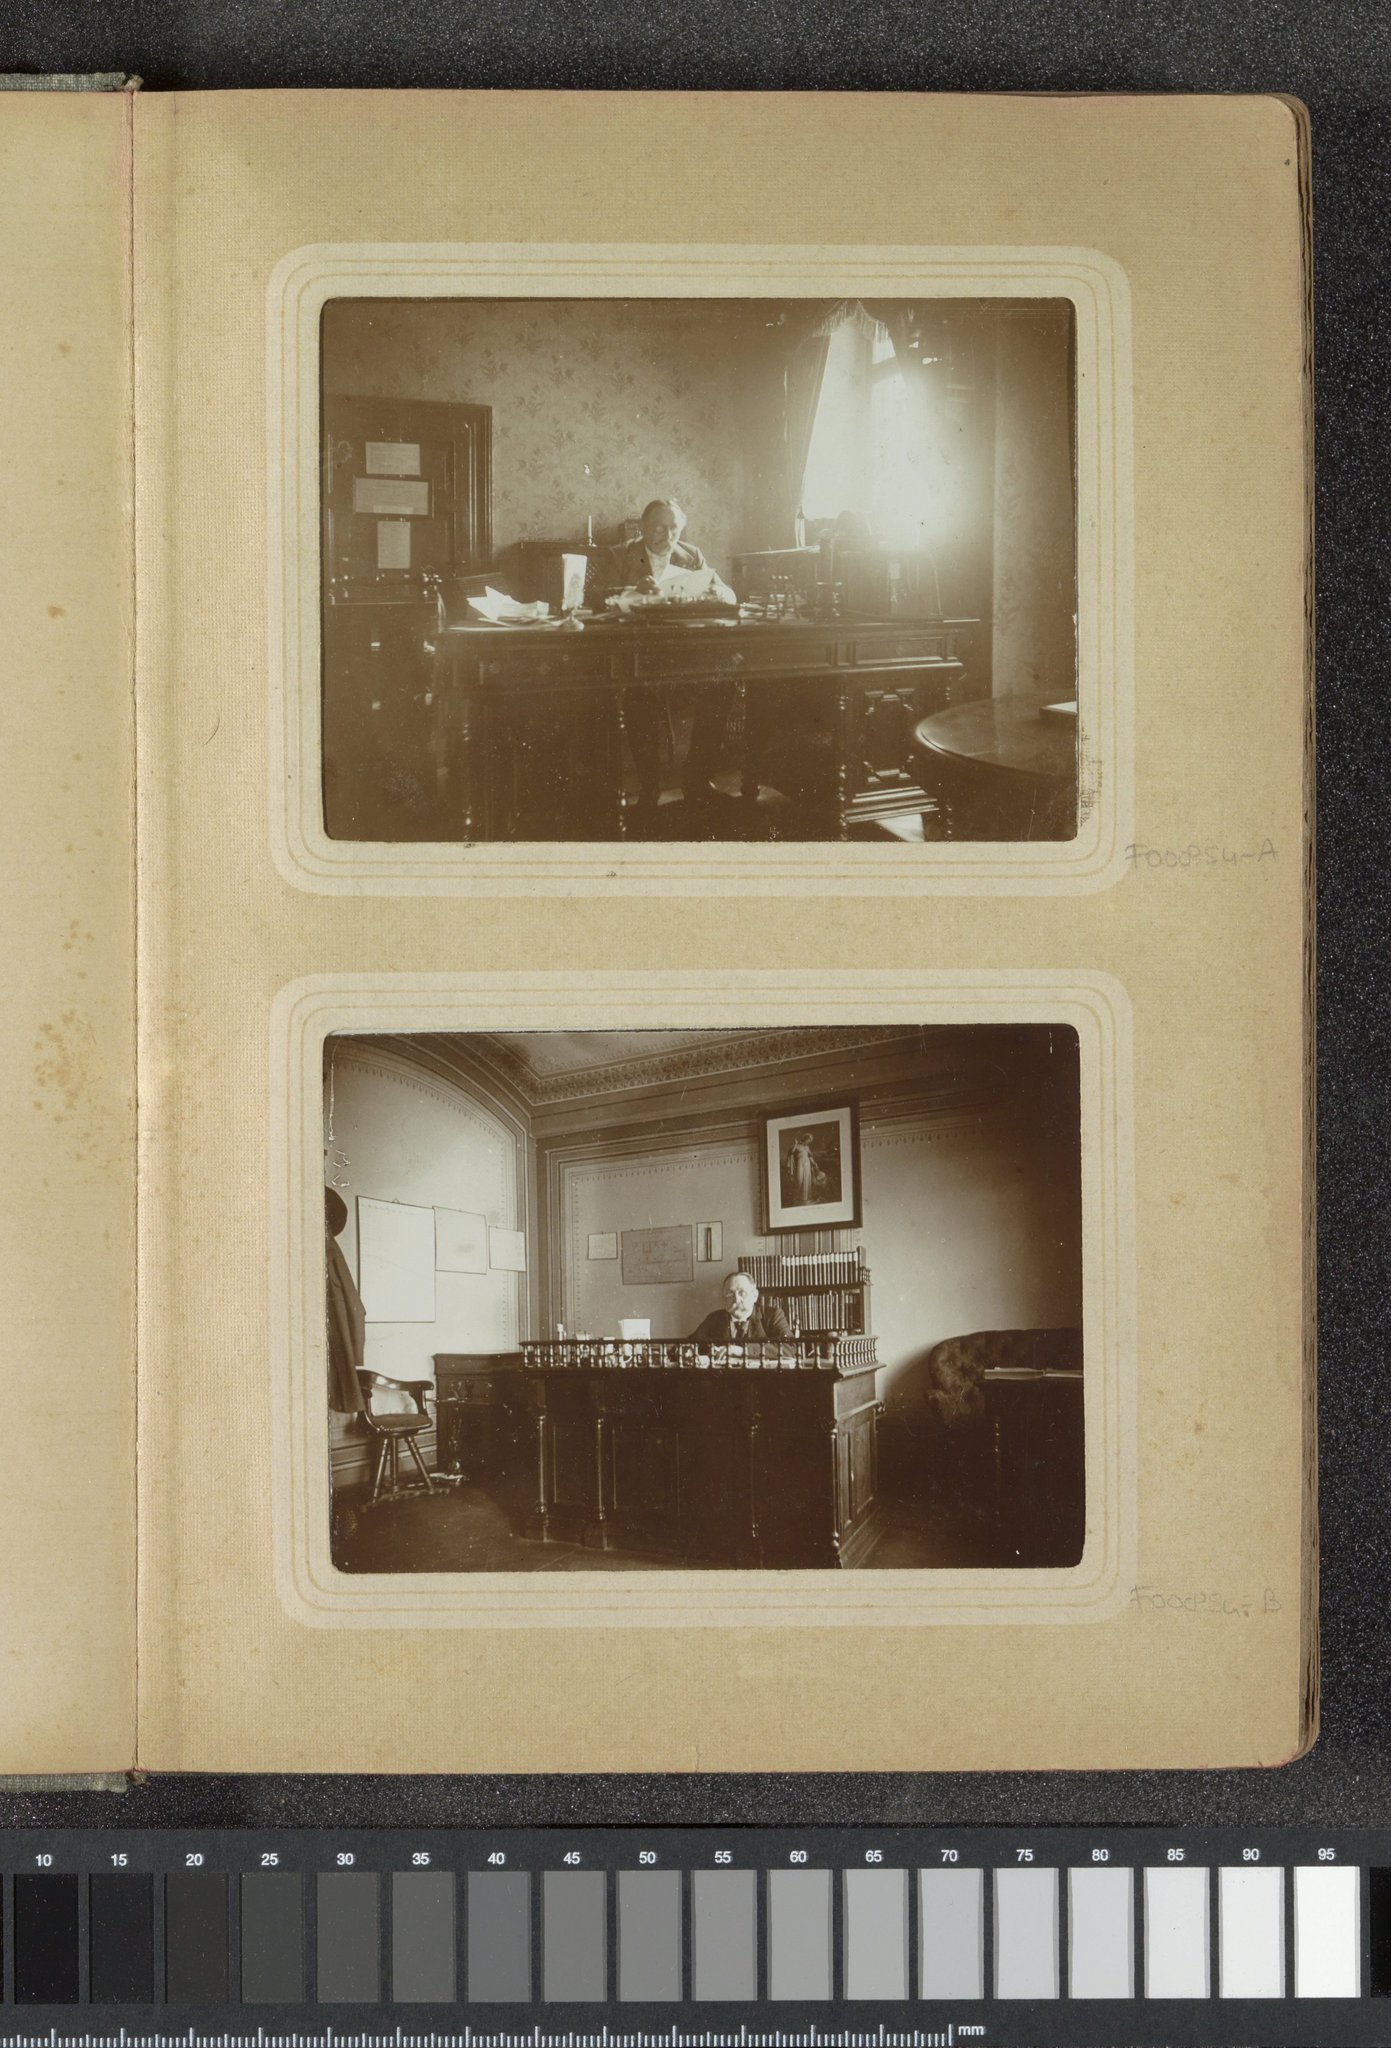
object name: photograph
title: Portret van een lezende man achter een bureau in een kamer in Duitsland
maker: Anonymous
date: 1890-1910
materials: cardboard, paper, photographic support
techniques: collodion silver print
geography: germany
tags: writing-table, writing-desk, reading, adult man, germany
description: Onderdeel van Fotoalbum van Carl Heinrich Fliegenschmidt, gevangenisdirecteur te Oslebshausen.